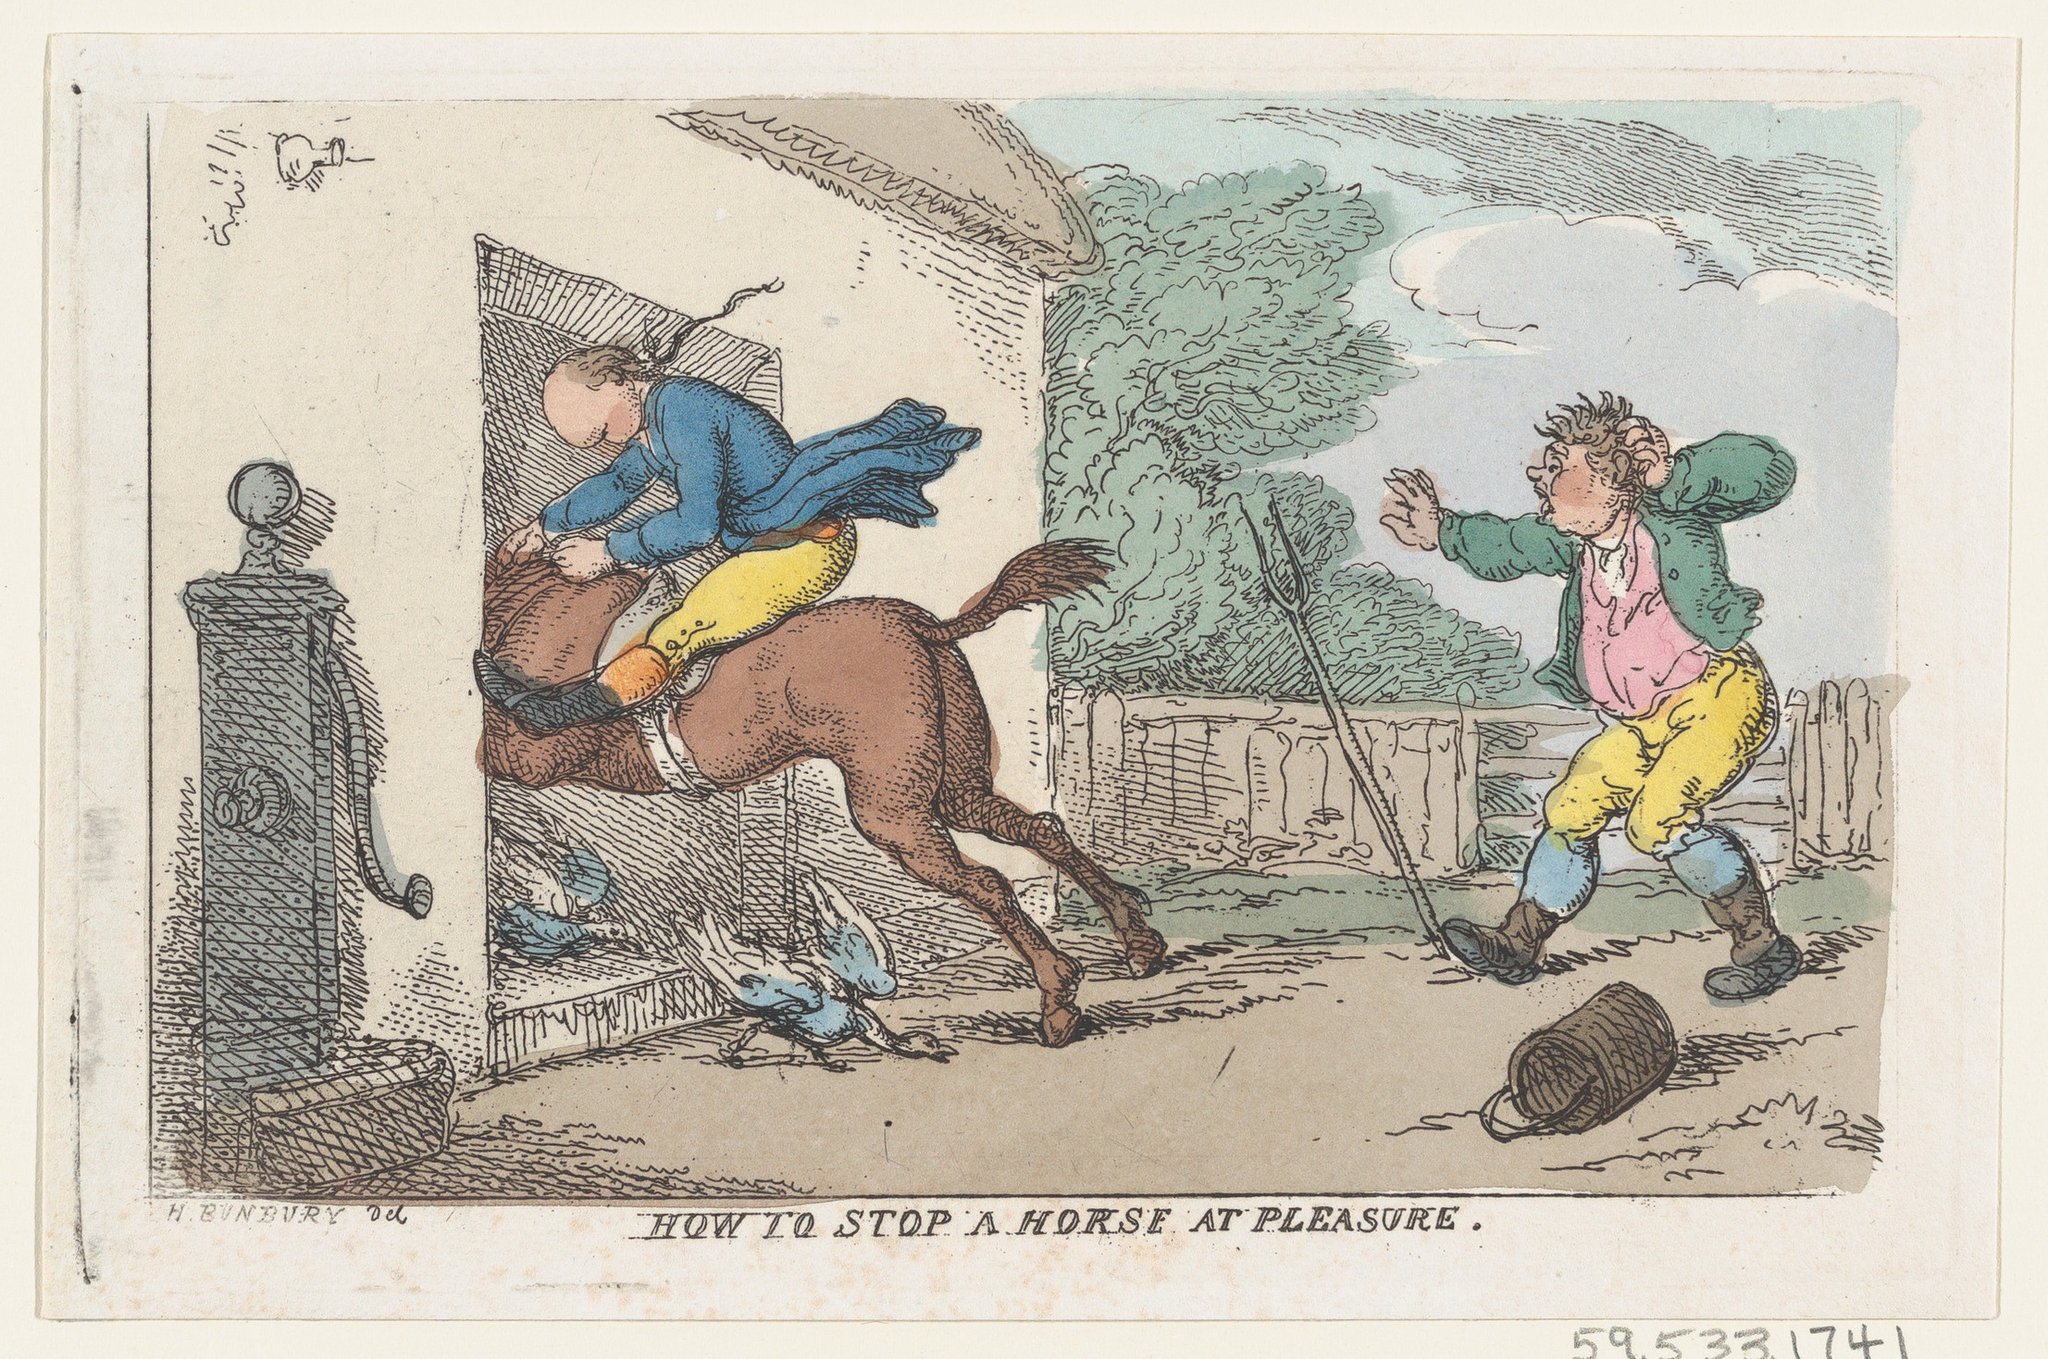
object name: print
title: How to Stop a Horse at Pleasure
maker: thomas rowlandson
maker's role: artist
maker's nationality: british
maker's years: 1757-1827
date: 1803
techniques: etching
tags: satire,men,horses